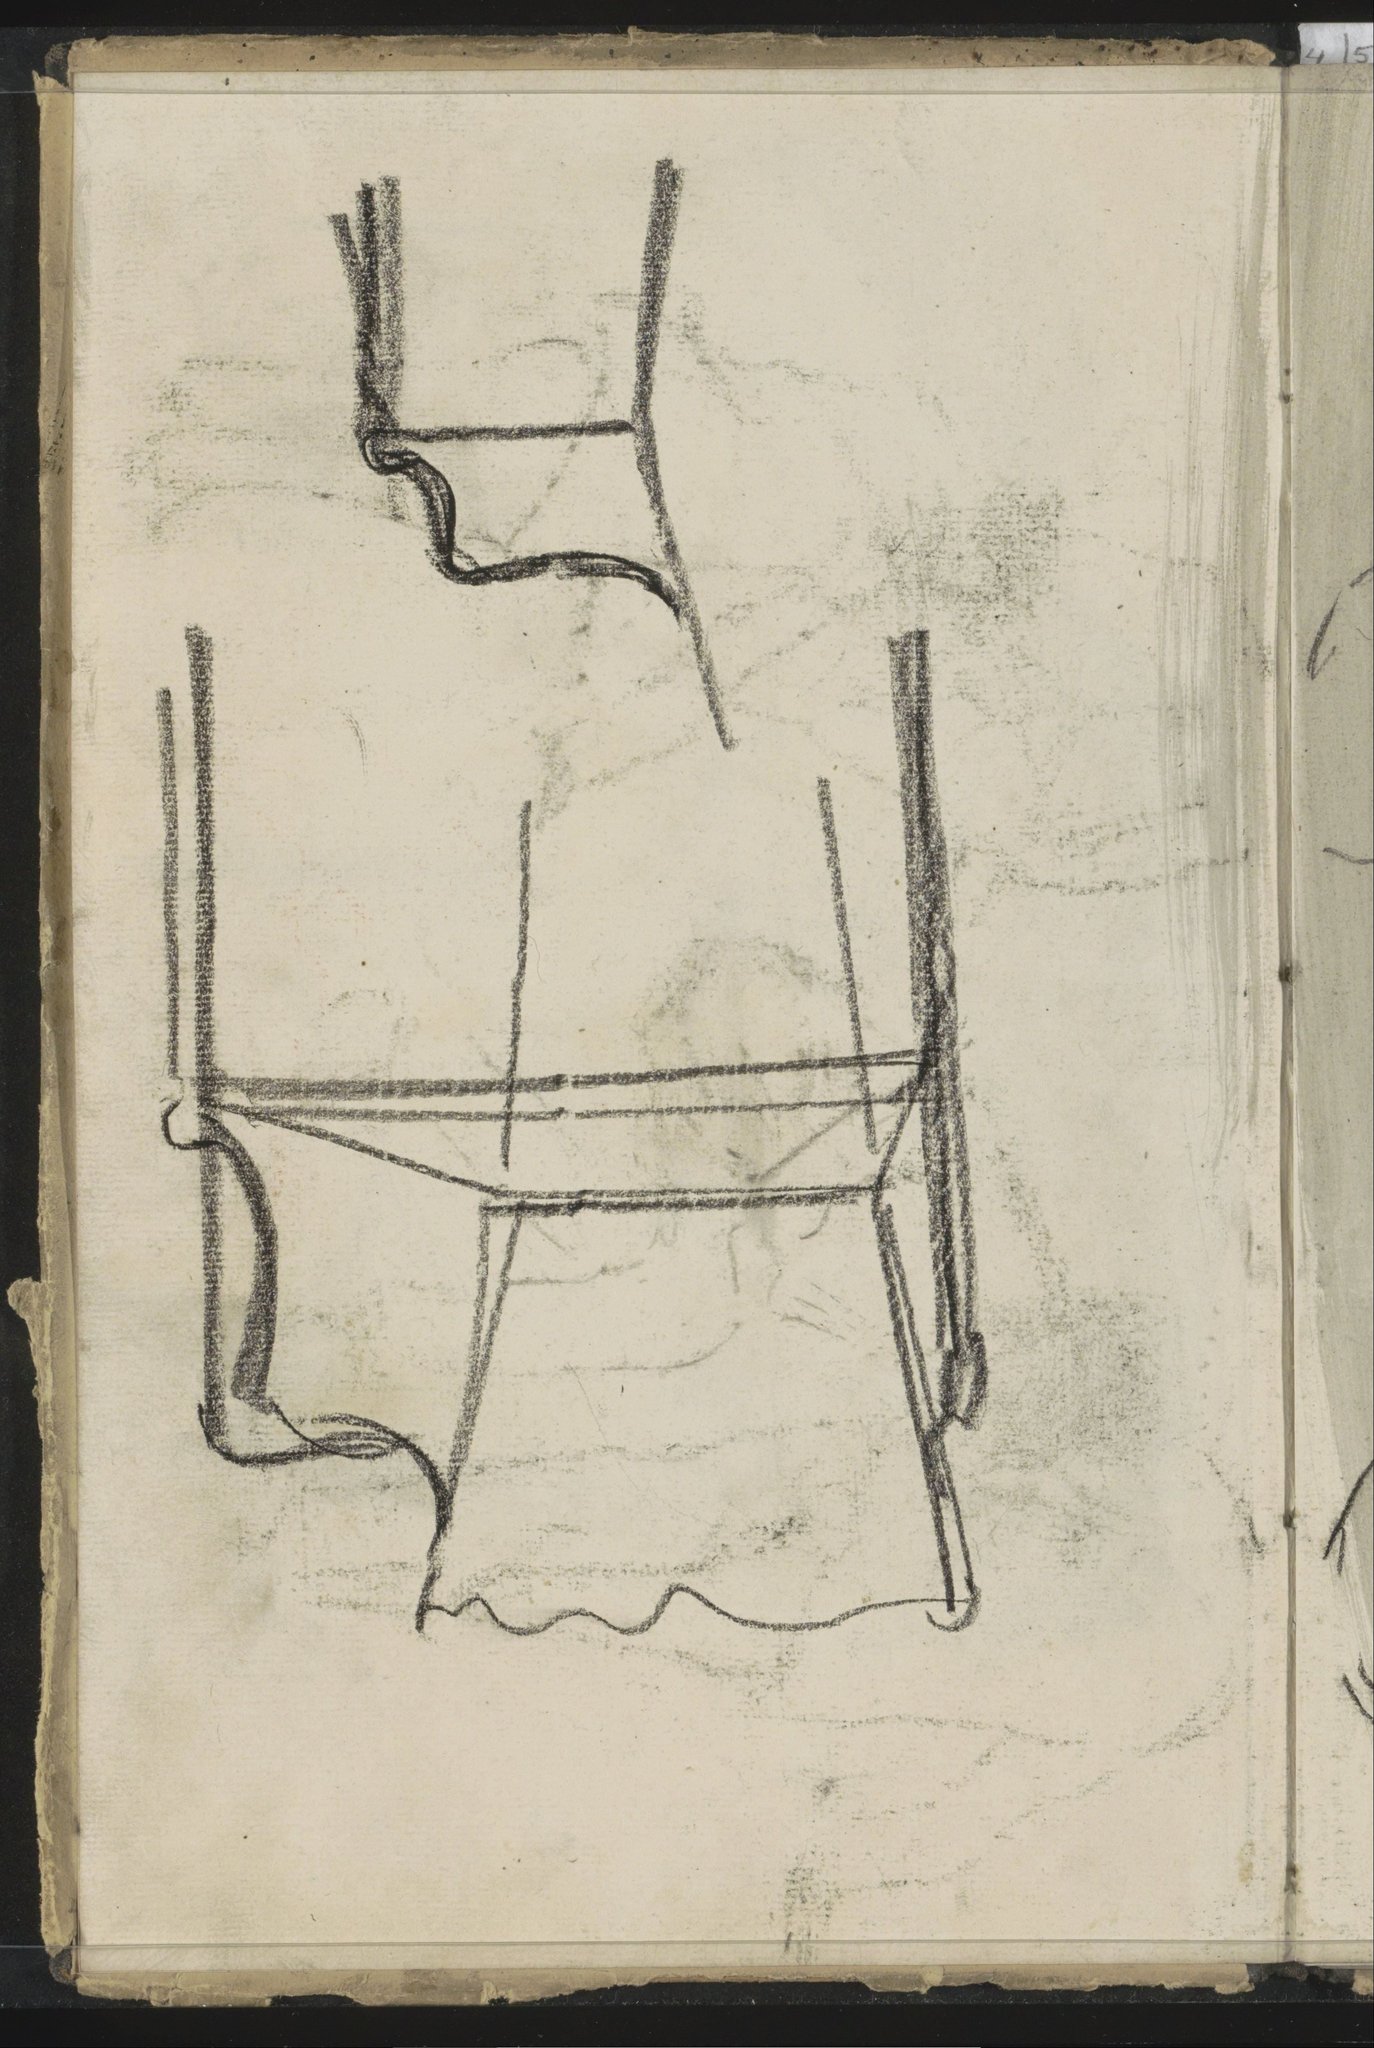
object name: sketchbook leaf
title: Stoel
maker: carel adolph lion cachet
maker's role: draughtsman, print maker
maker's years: 1864-1945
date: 1890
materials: chalk, paper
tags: chair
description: Blad 1 verso uit een schetsboek met 38 bladen.